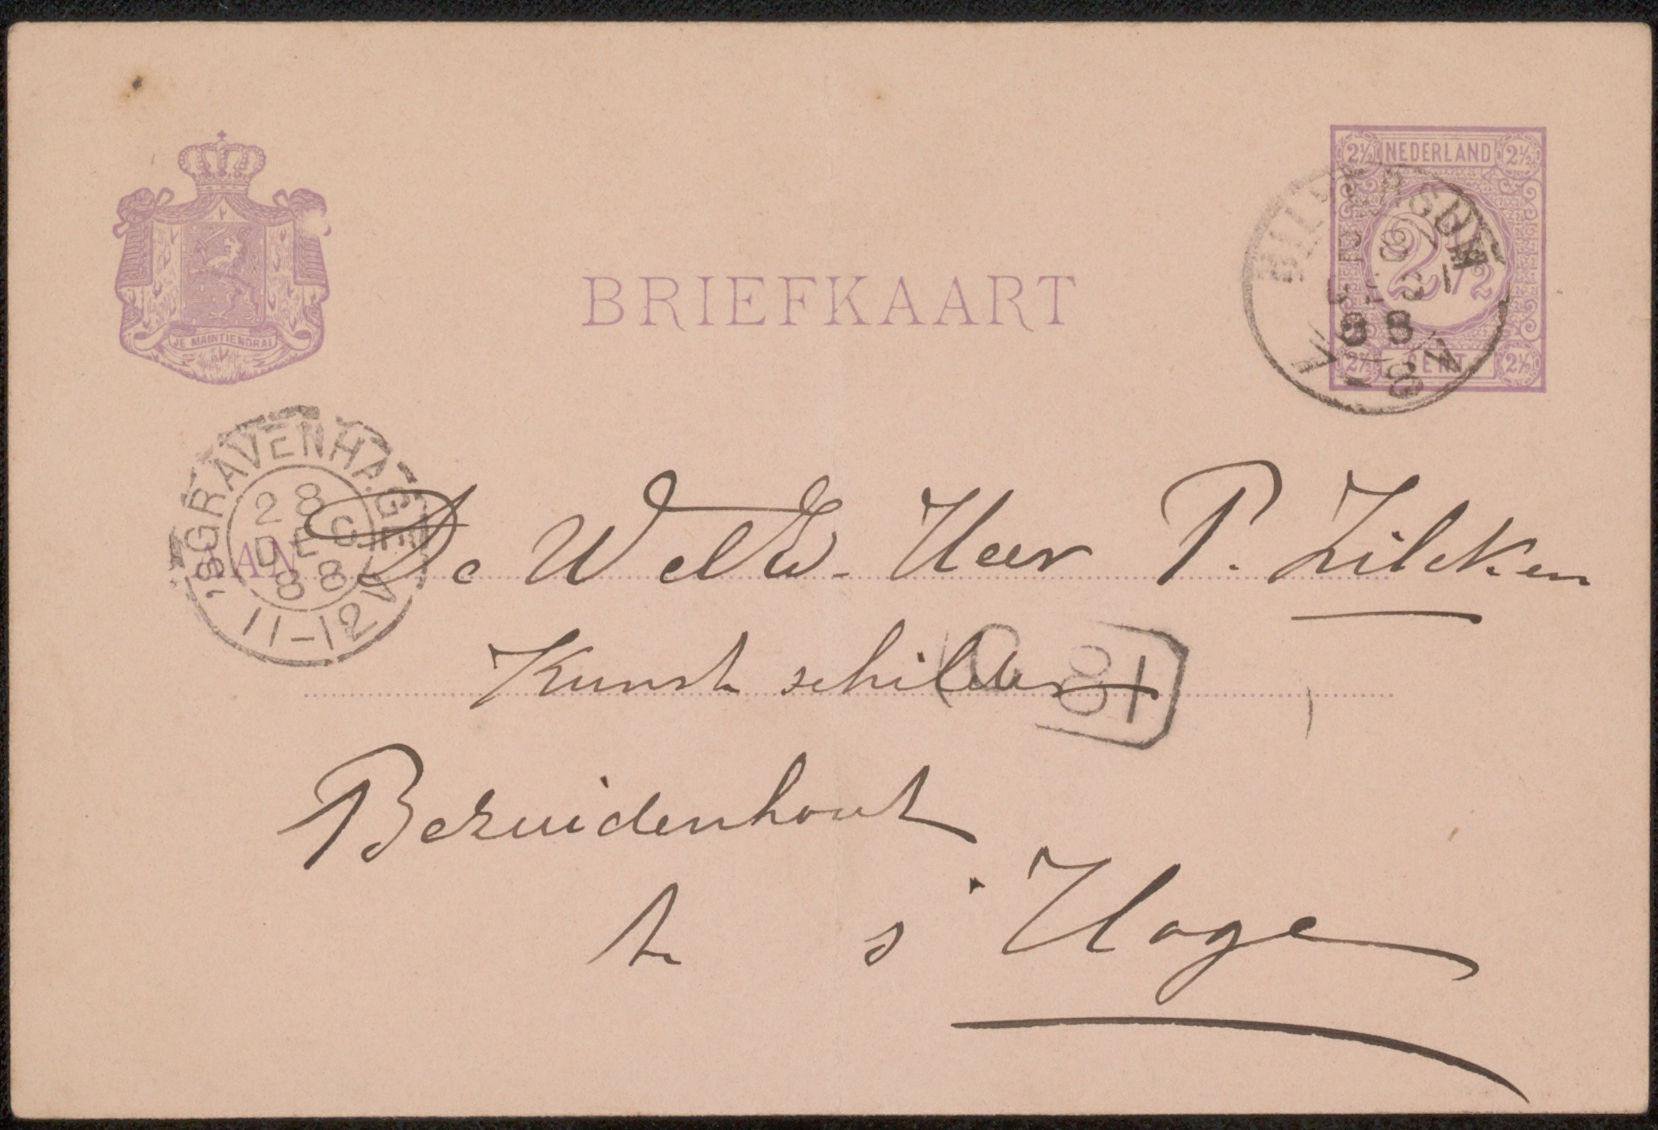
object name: postcard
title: Briefkaart aan Philip Zilcken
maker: margaretha roosenboom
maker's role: draughtsman, painter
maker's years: 1843-1896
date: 1888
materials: cardboard, ink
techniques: pen, writing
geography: hilversum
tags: philip zilcken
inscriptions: collector's mark: ‘RPK’